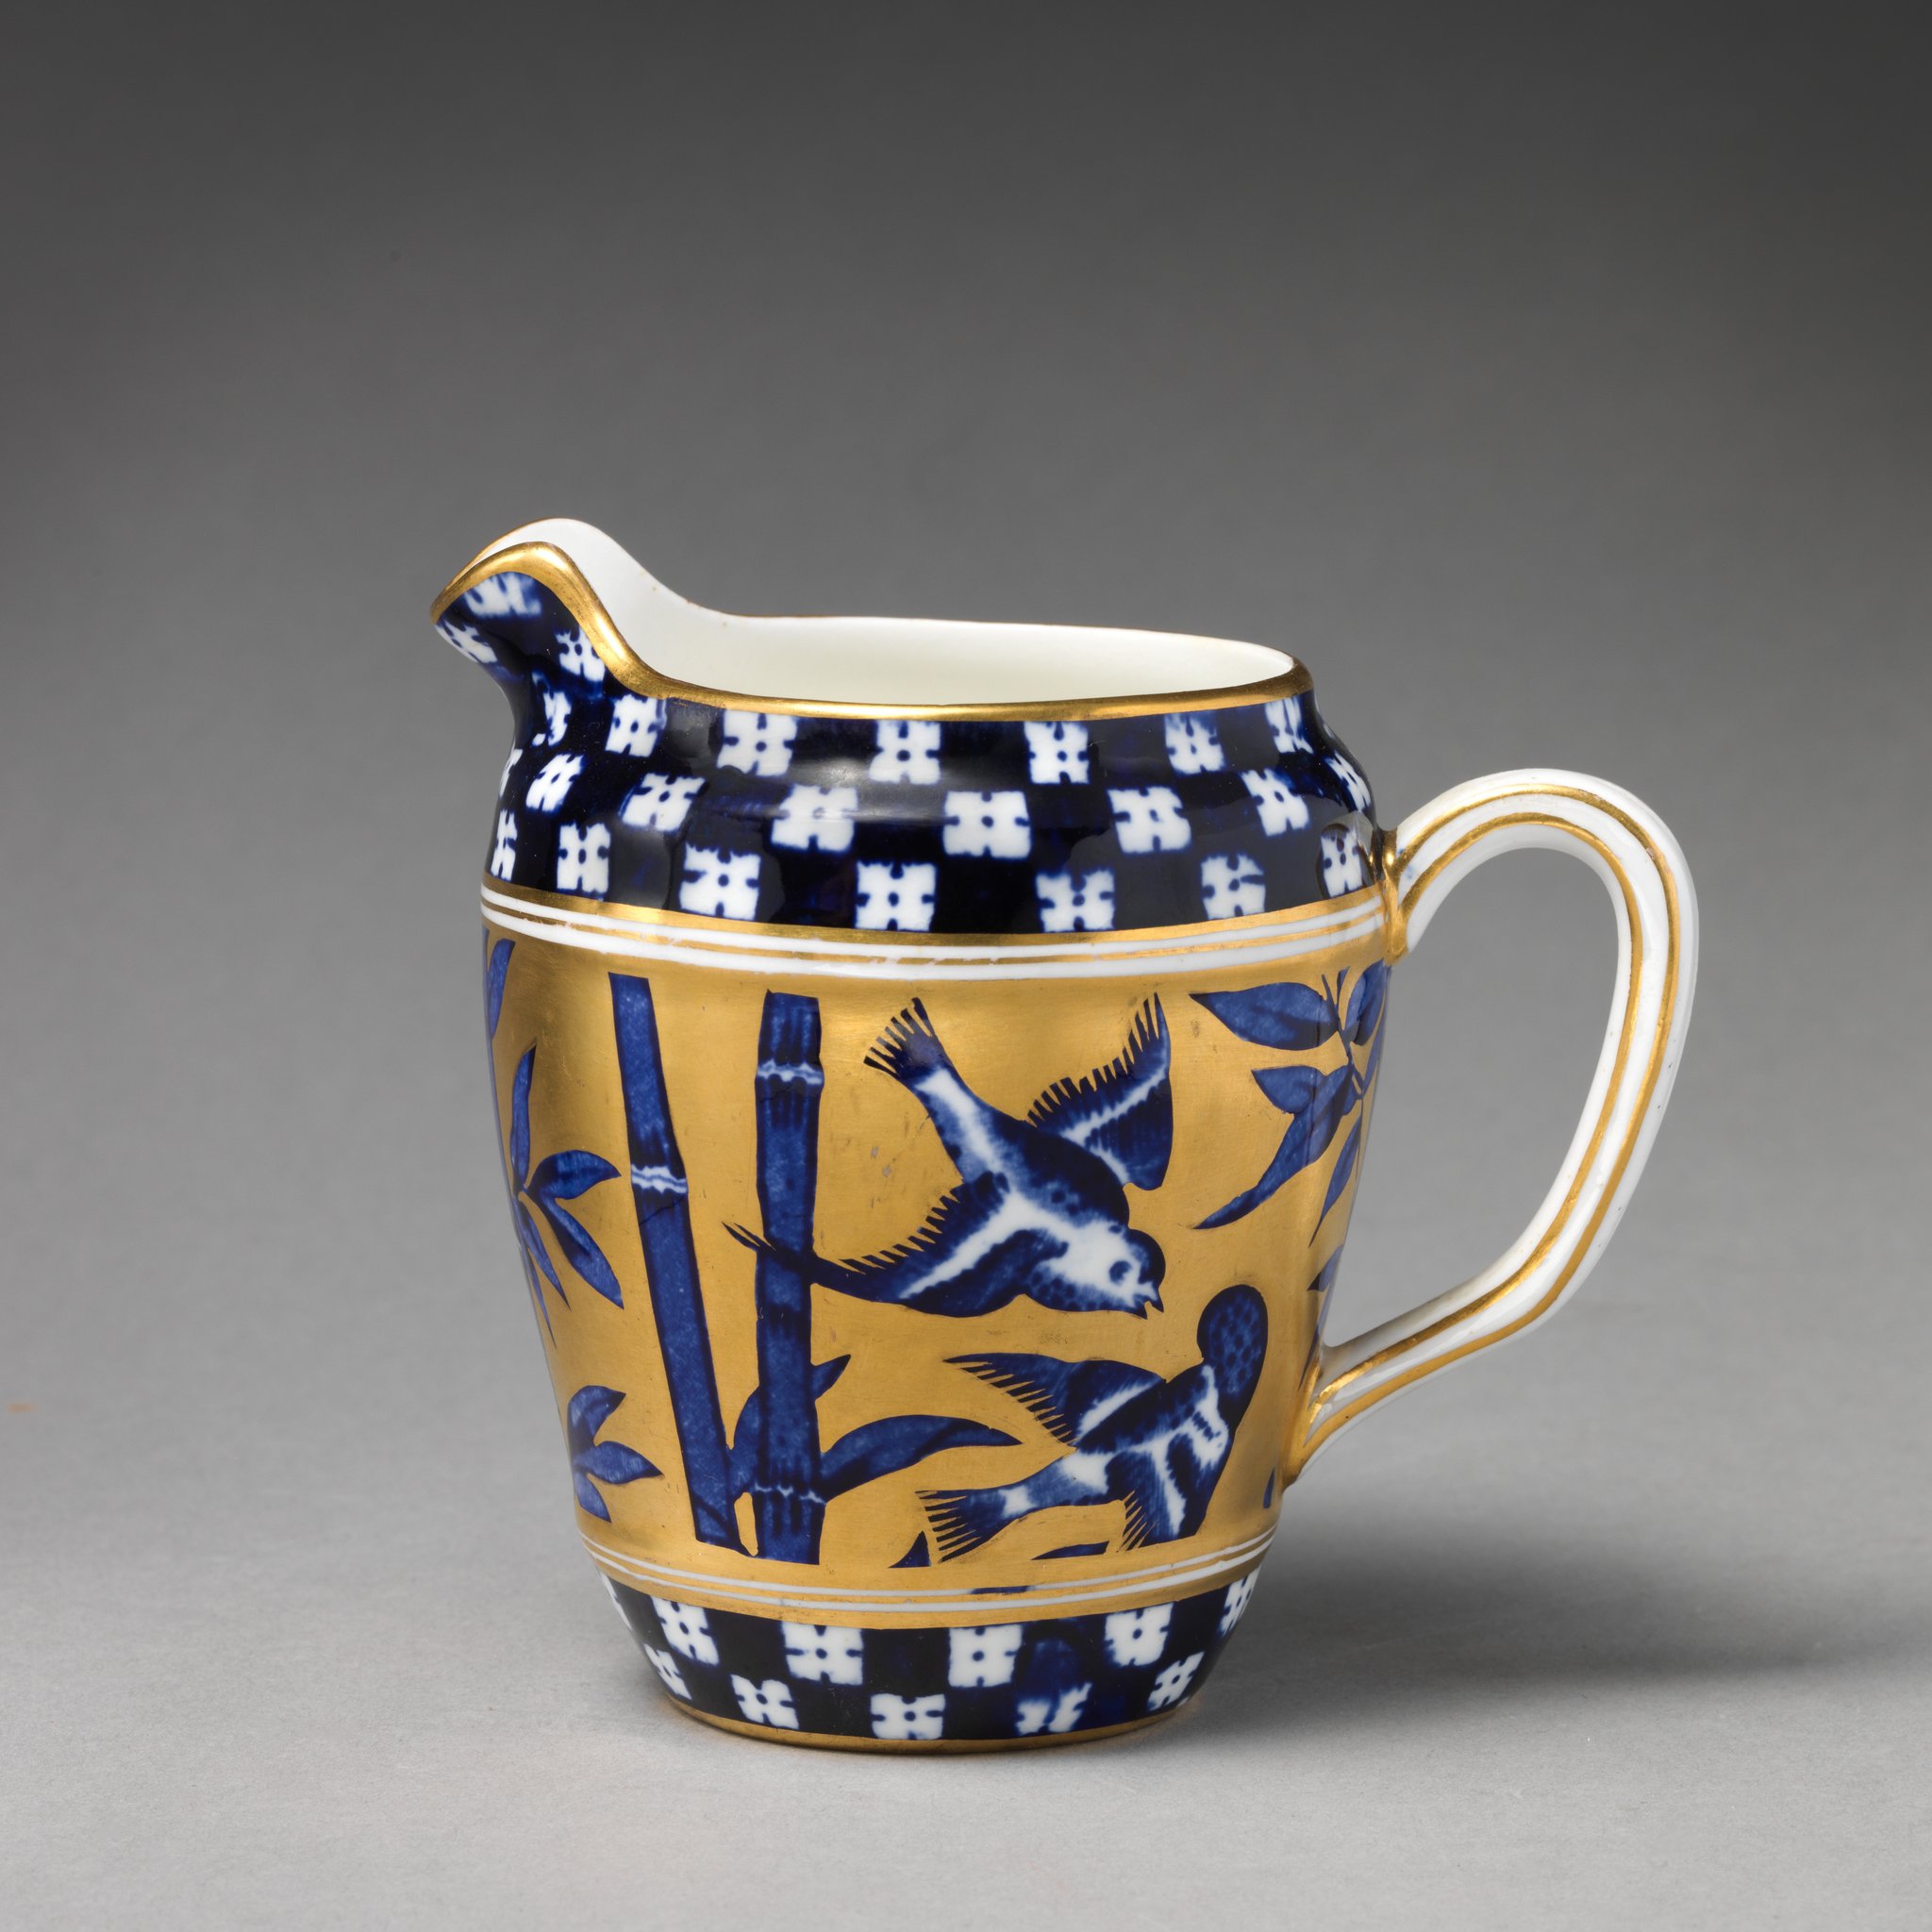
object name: creamer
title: Creamer (part of a service)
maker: coalport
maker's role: maker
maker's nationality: british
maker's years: 1794-1926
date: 1891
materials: porcelain